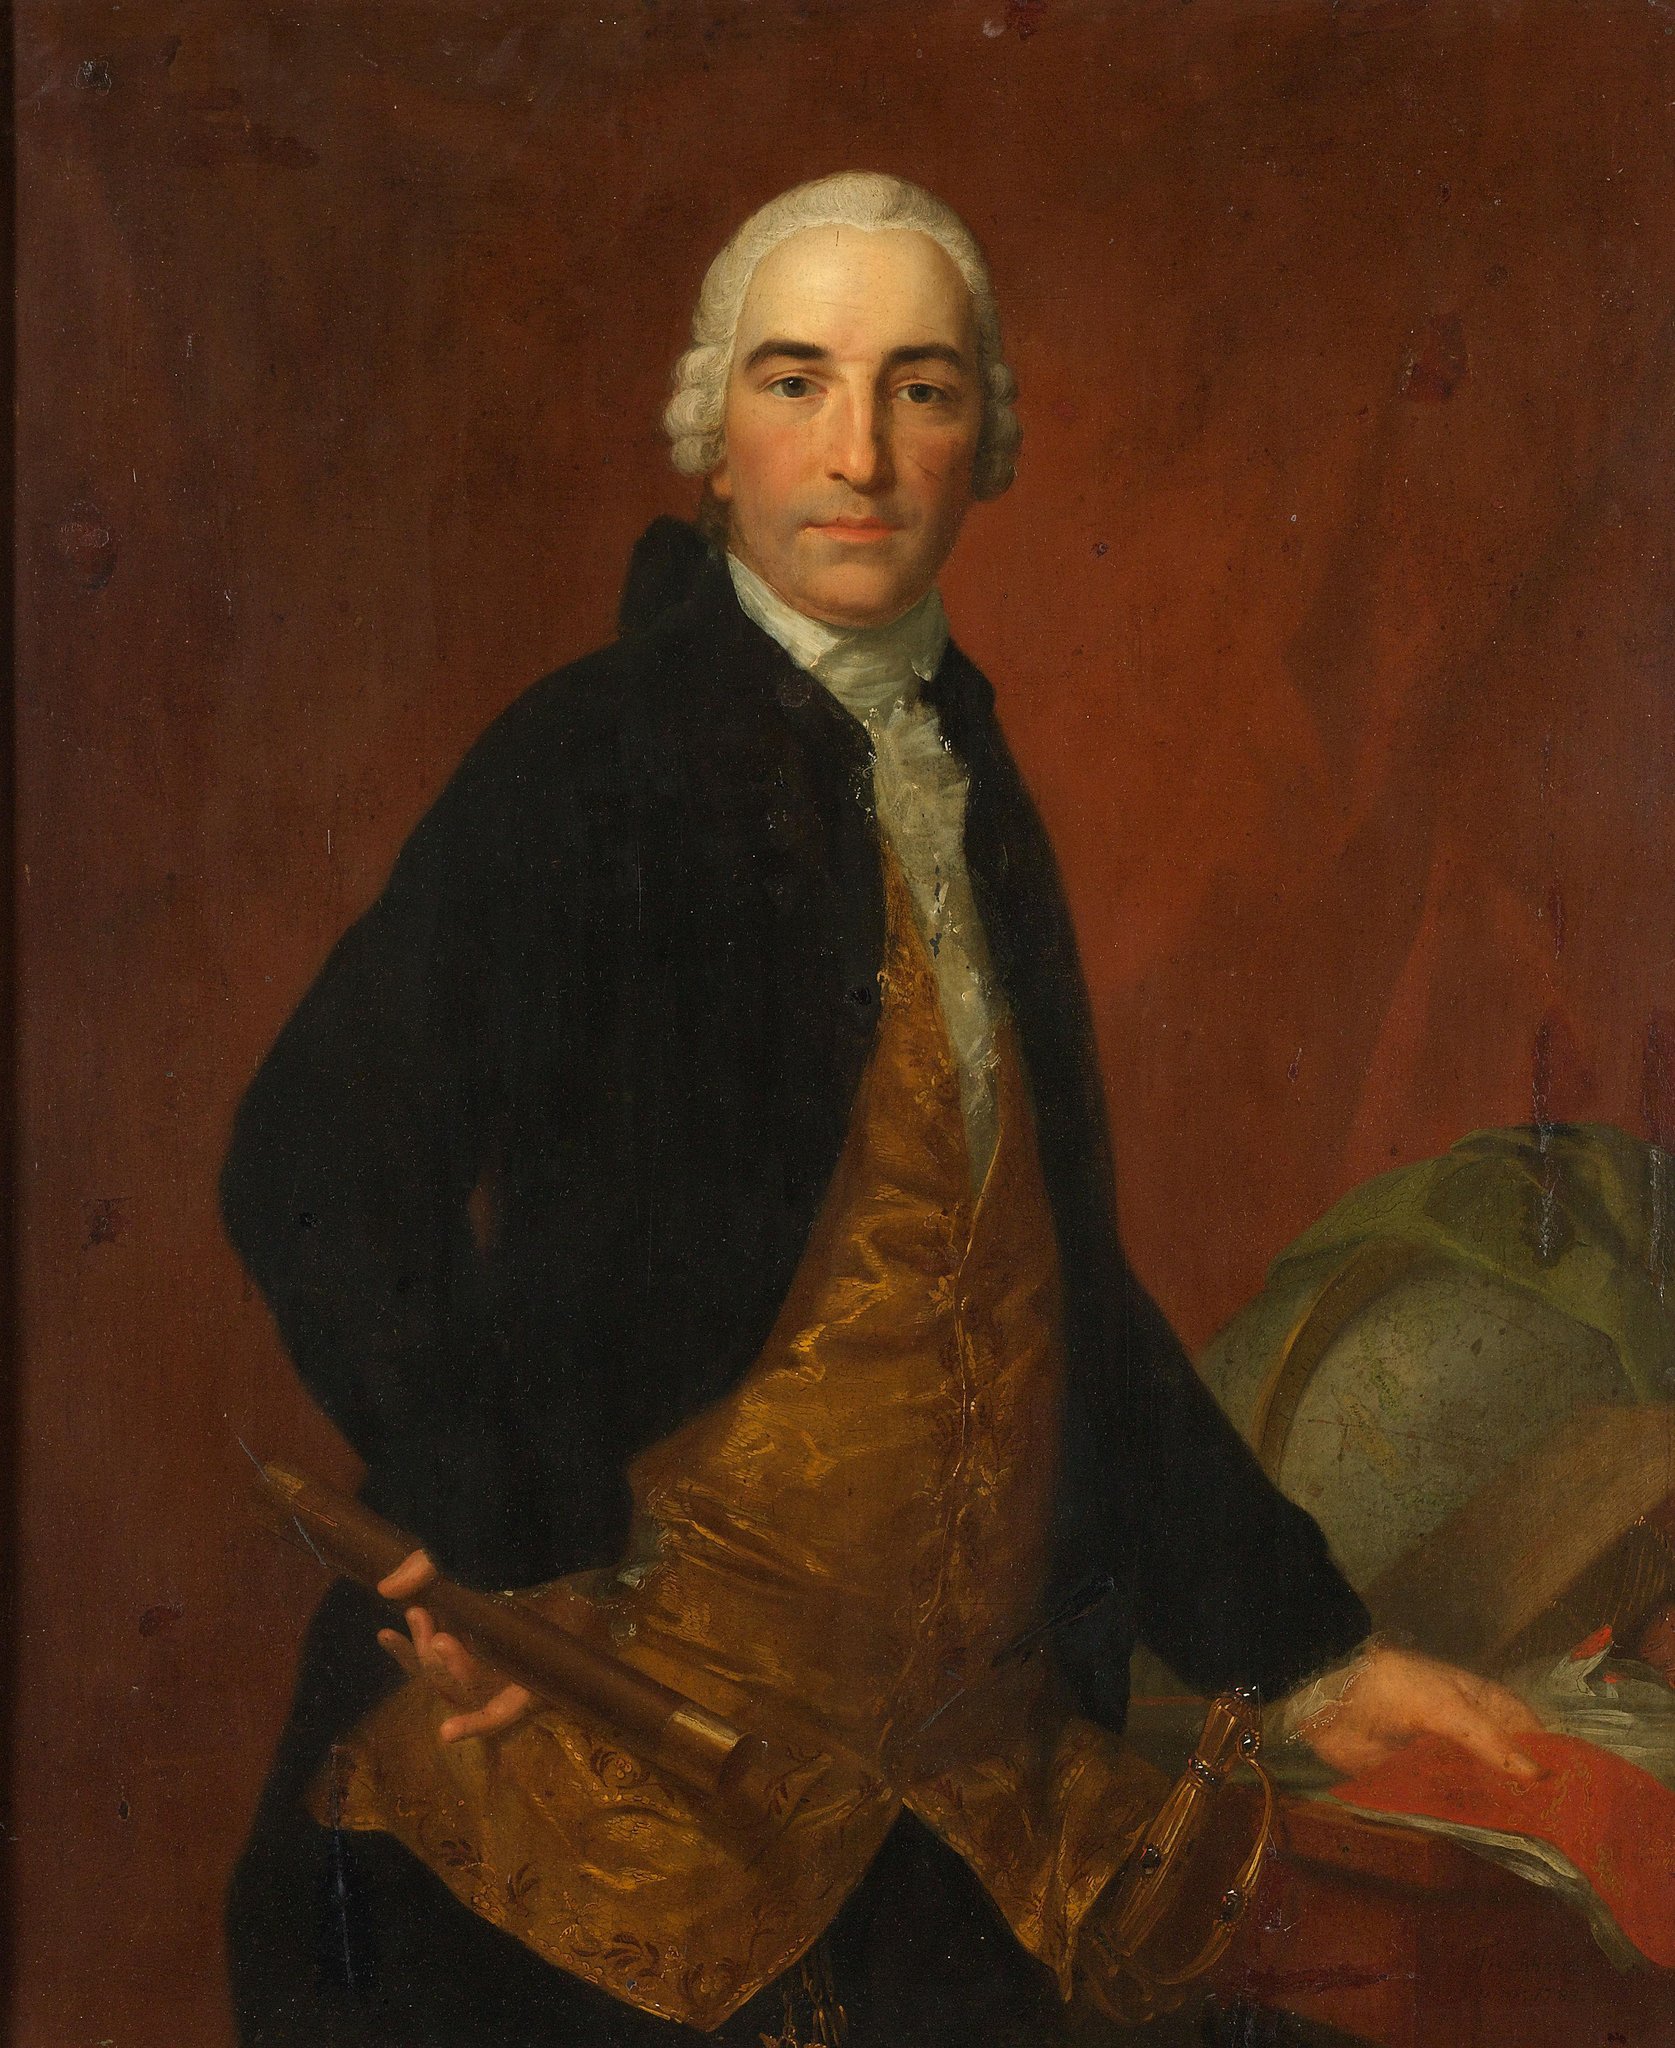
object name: painting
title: Portrait of Willem Arnold Alting, Governor-General of the Dutch East India Company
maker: johann friedrich august tischbein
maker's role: painter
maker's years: 1750-1812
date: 1788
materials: brass, oil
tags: colonial governor, historical persons, baton of general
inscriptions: signature and date: ‘Tischbein pinx. 1788’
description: Portret van Willem Arnold Alting (1724-1800). Gouverneur-generaal (1780-97). Heupstuk, staande naar rechts. Commandostaf in de rechterhand, in de linkerhand neemt hij een portefeuille van een tafel waarop enkele boeken en documenten en een globe. Geschilderd op een koperen plaat, oorspronkelijk gebruikt als drukplaat voor textiel. Onderdeel van een reeks van portretten van de gouverneurs-generaal van het voormalige Nederlands Oost-Indië.